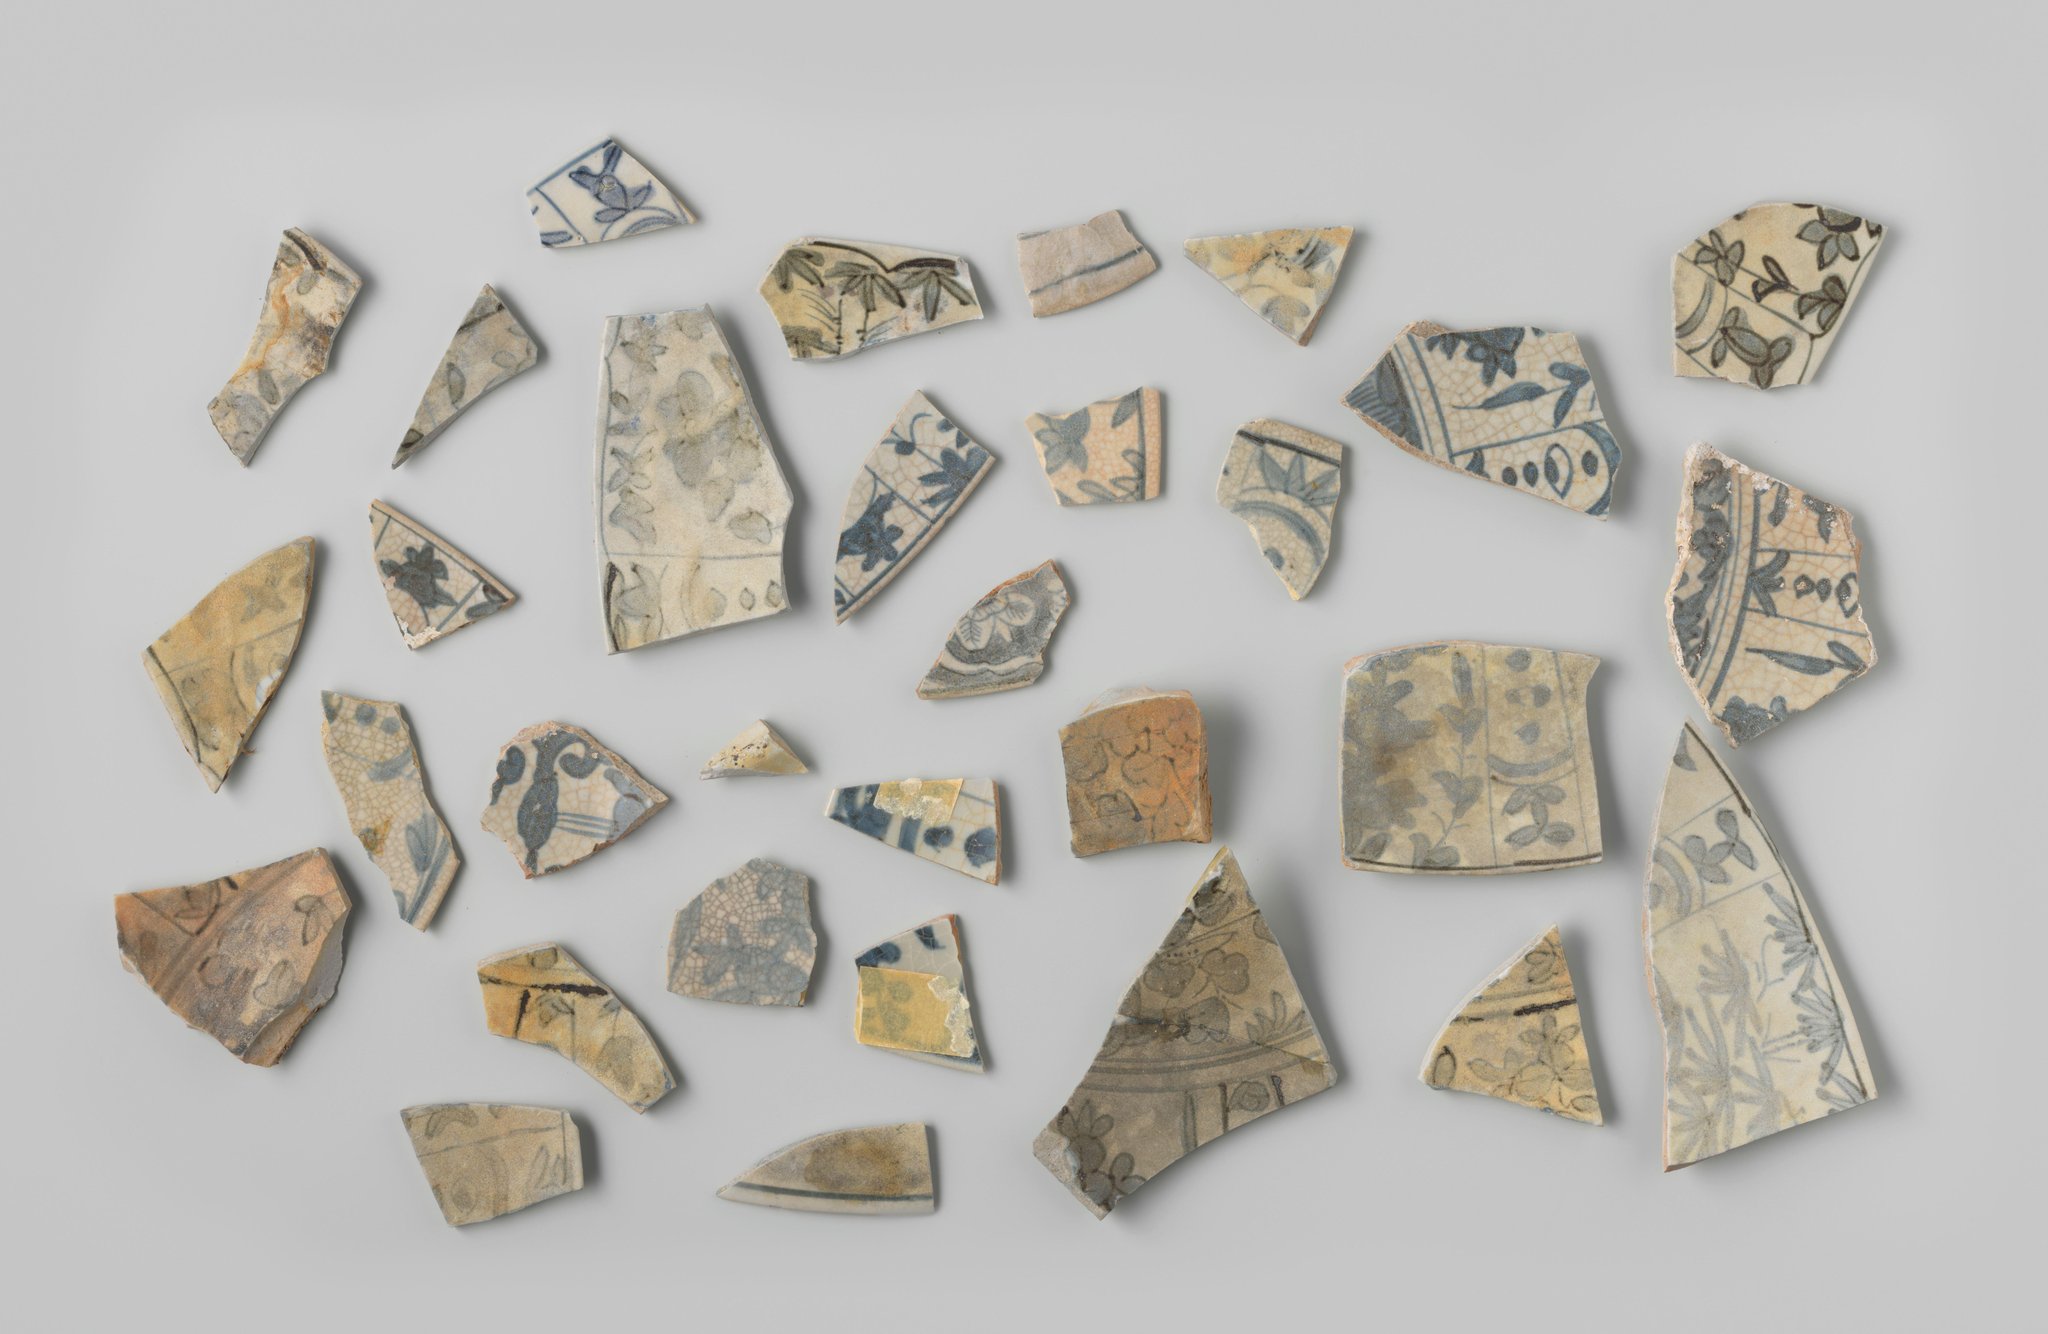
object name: sherd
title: Scherven van een bord uit V.O.C.-schip de 'Witte Leeuw'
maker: Anonymous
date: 1613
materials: bone china, porcelain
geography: shantou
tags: verenigde oostindische compagnie, sint-helena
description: A dish. The bottom is completely glazed, coarse sand grains cover the footrim. In the centre a phoenix standing looking to the left where there is rocks, water, bamboo and grasses; on the right a peony tree. The broad panels contain a stem with three peaches, twice a spray of bamboo. The narrow panels have a row of dots with a peach on top. On the outside an elongated spray with a peach.